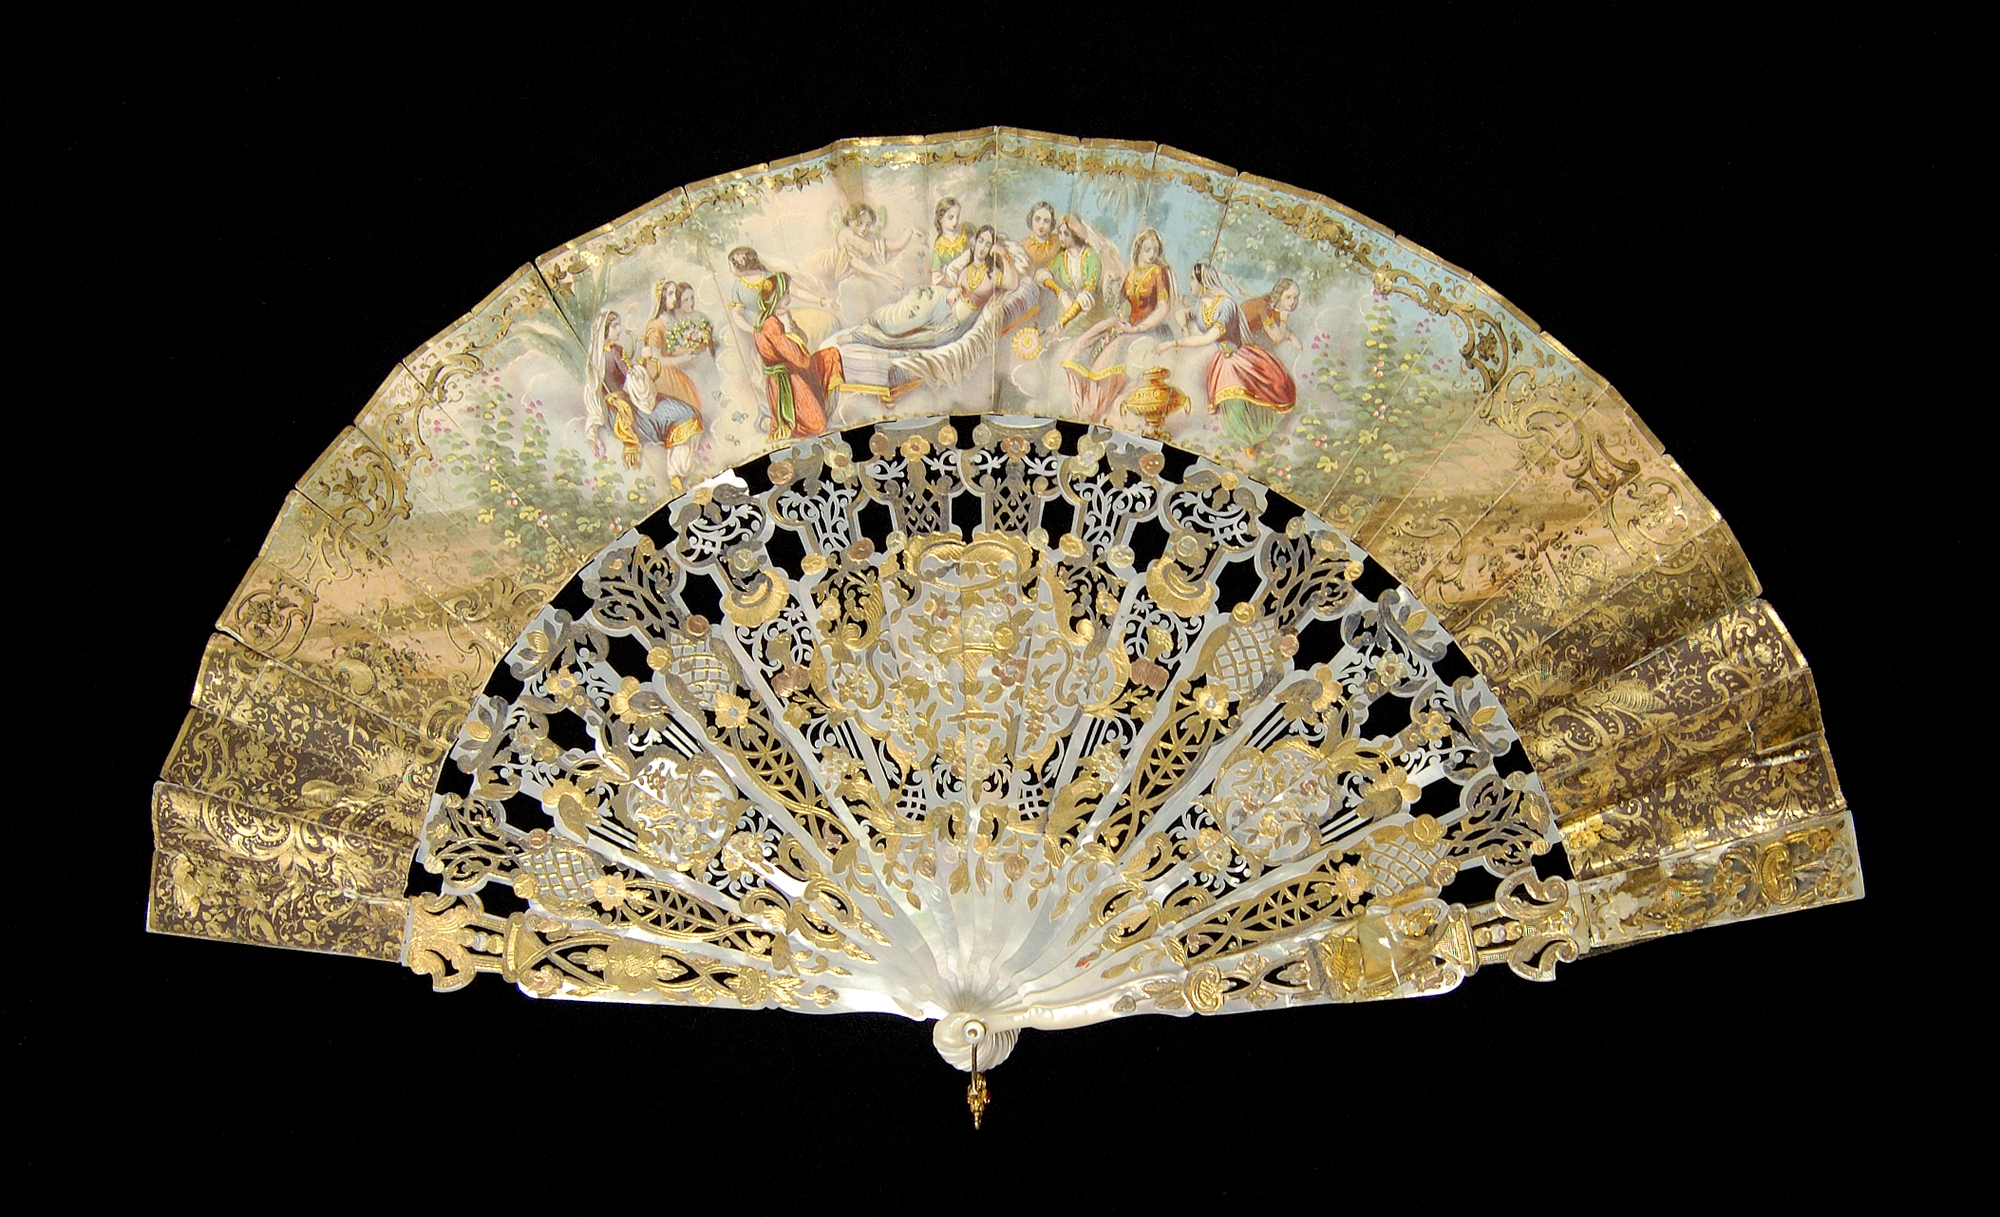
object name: fan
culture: italian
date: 1860-1869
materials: metal, mother of pearl, paper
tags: women